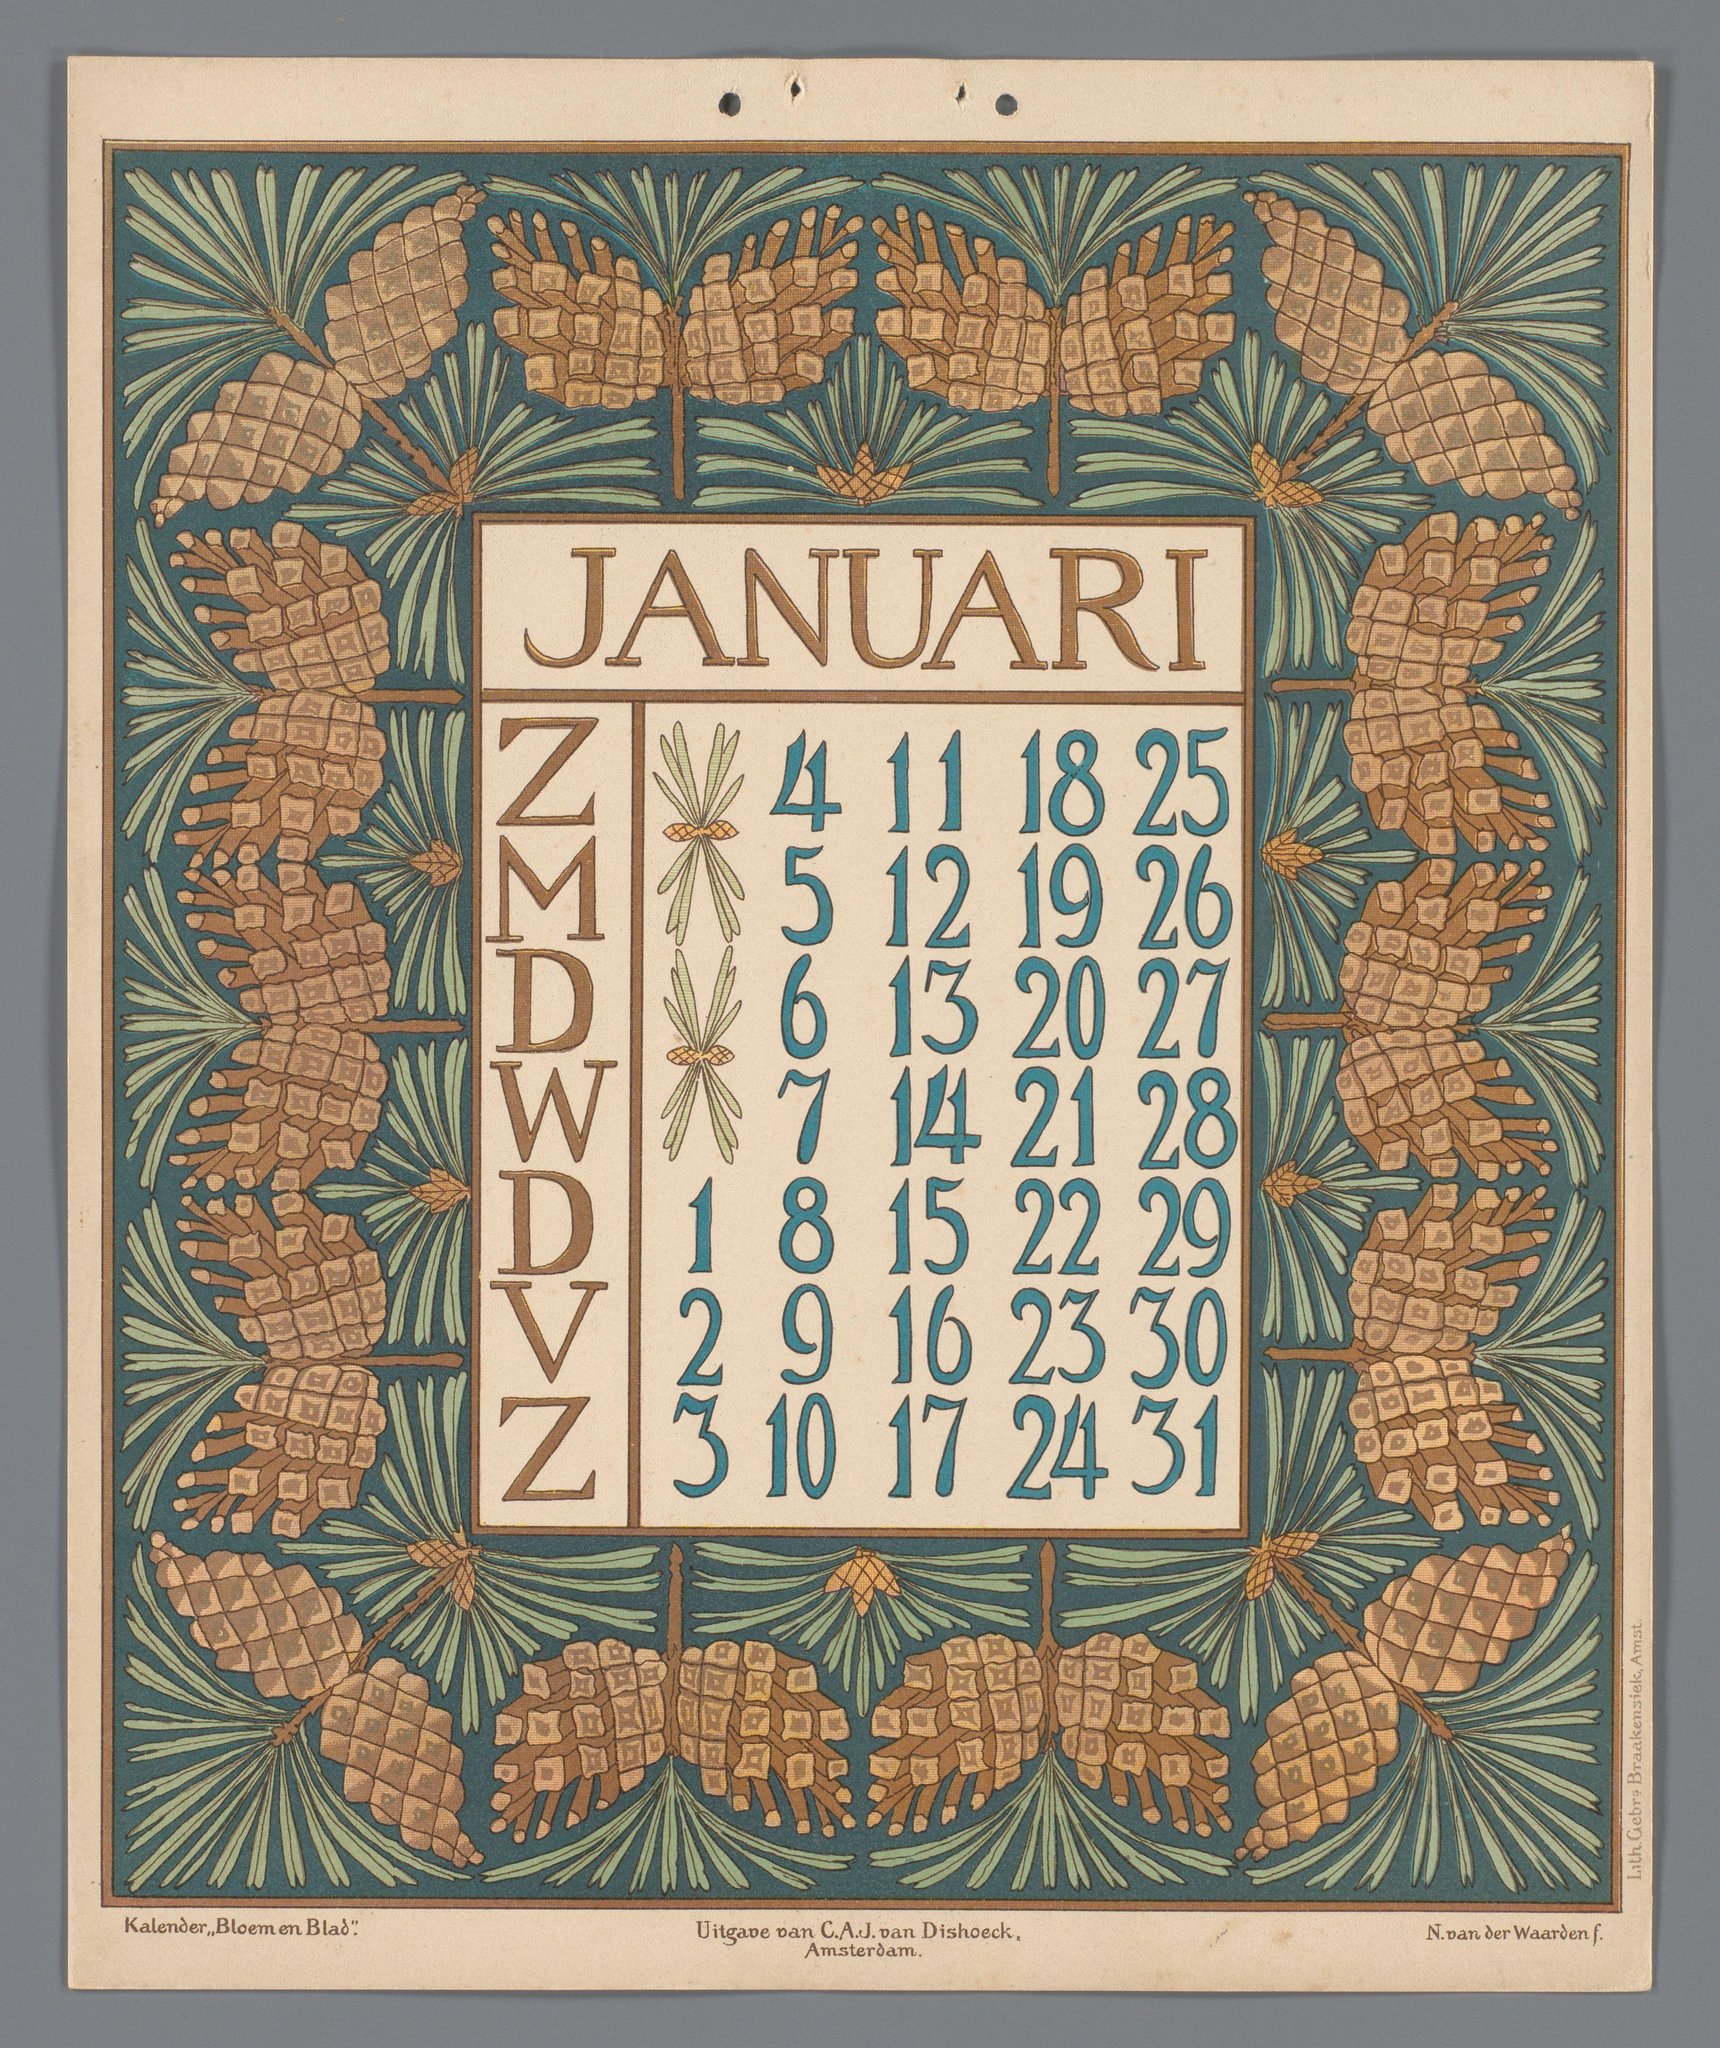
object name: calendar leaf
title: Kalenderblad voor januari van de kalender 'Bloem en blad'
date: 1900-1910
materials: cordage, paper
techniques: lithograph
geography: amsterdam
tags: flowers, ornaments ~ art, calendar, almanac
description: Randdecoratie van dennenappels en dennennaalden.